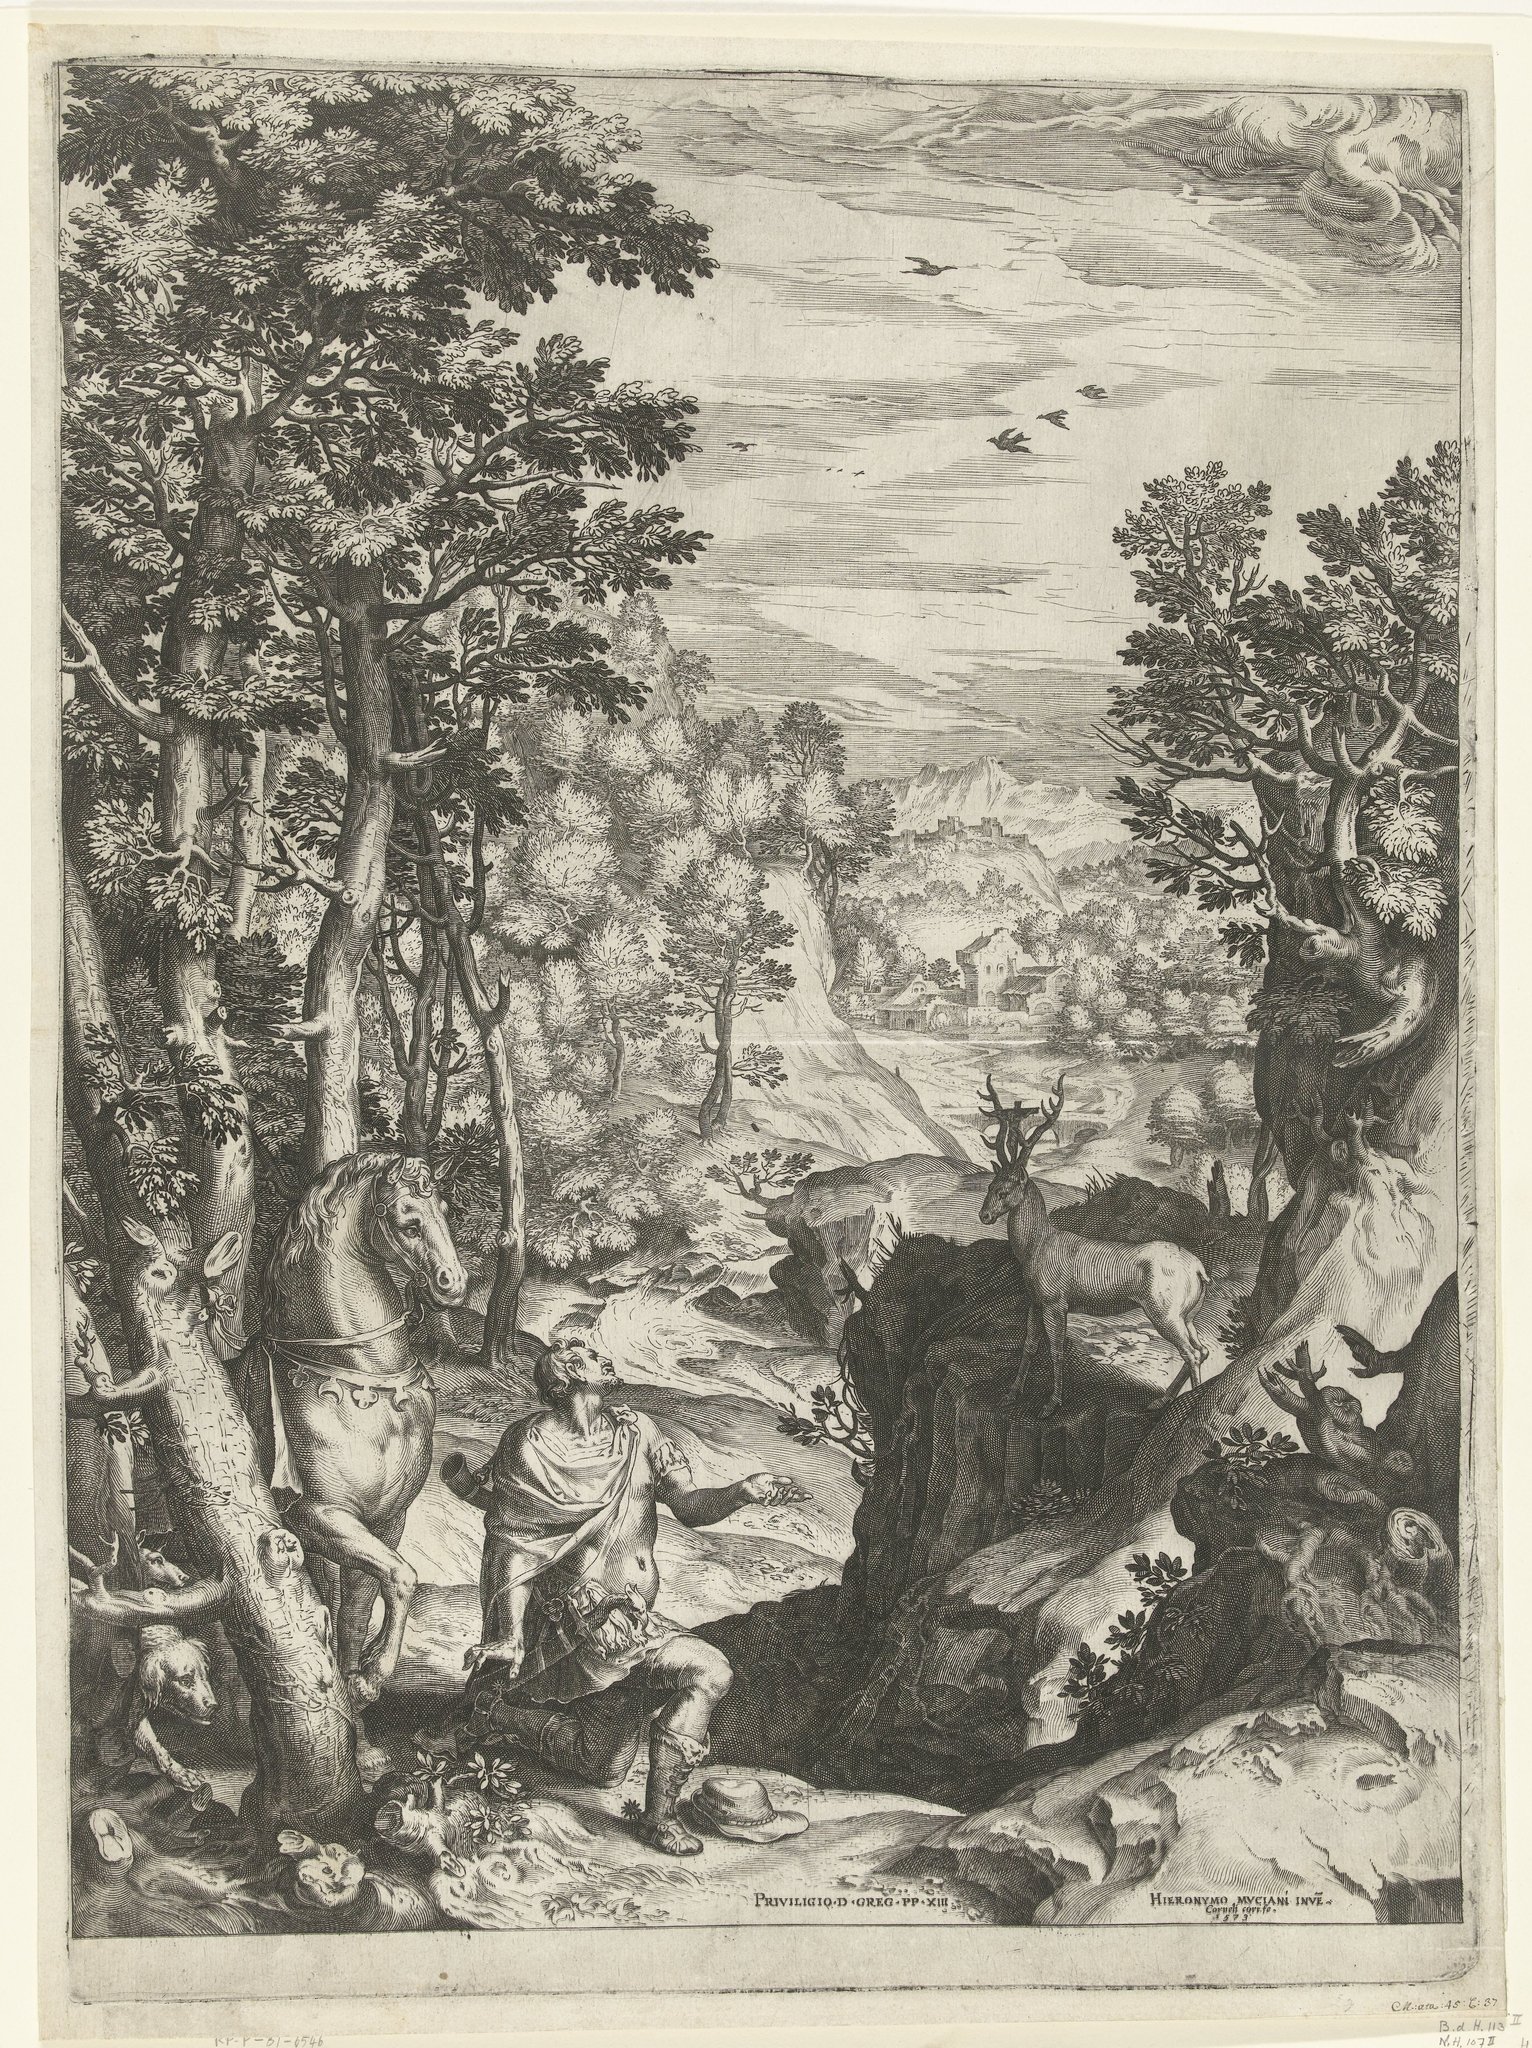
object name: print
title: Landschap met het visioen van Eustachius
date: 1573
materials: paper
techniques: engraving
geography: rome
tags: the conversion of st. eustace: while hunting (on horseback) he is confronted with a stag bearing a crucifix between its antlers; eustace is shown kneeling before the stag (that appears on a rock)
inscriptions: collector's mark: Lugt 240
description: Eustachius verschijnt onderweg in het bos een hert met een crucifix in het gewei. Eustachius draagt de kleding van een Romeinse soldaat. Hij stapt van zijn paard en knielt in aanbidding voor het hert.